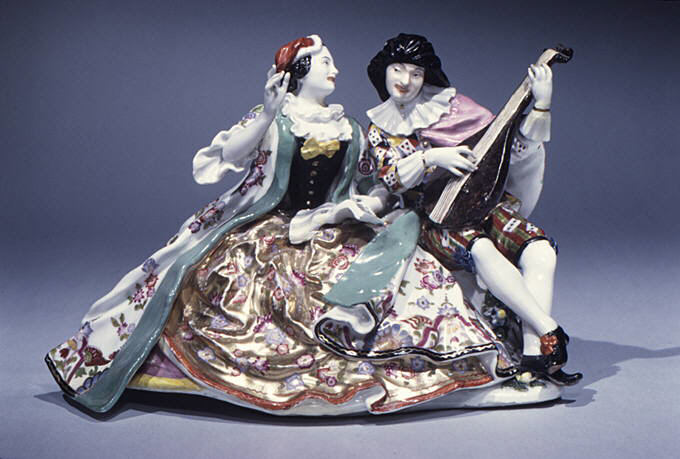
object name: group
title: Scaramouche and Columbine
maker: meissen manufactory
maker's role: manufactory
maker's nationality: german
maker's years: 1710-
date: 1741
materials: hard paste porcelain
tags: musical instruments,men,women,flowers